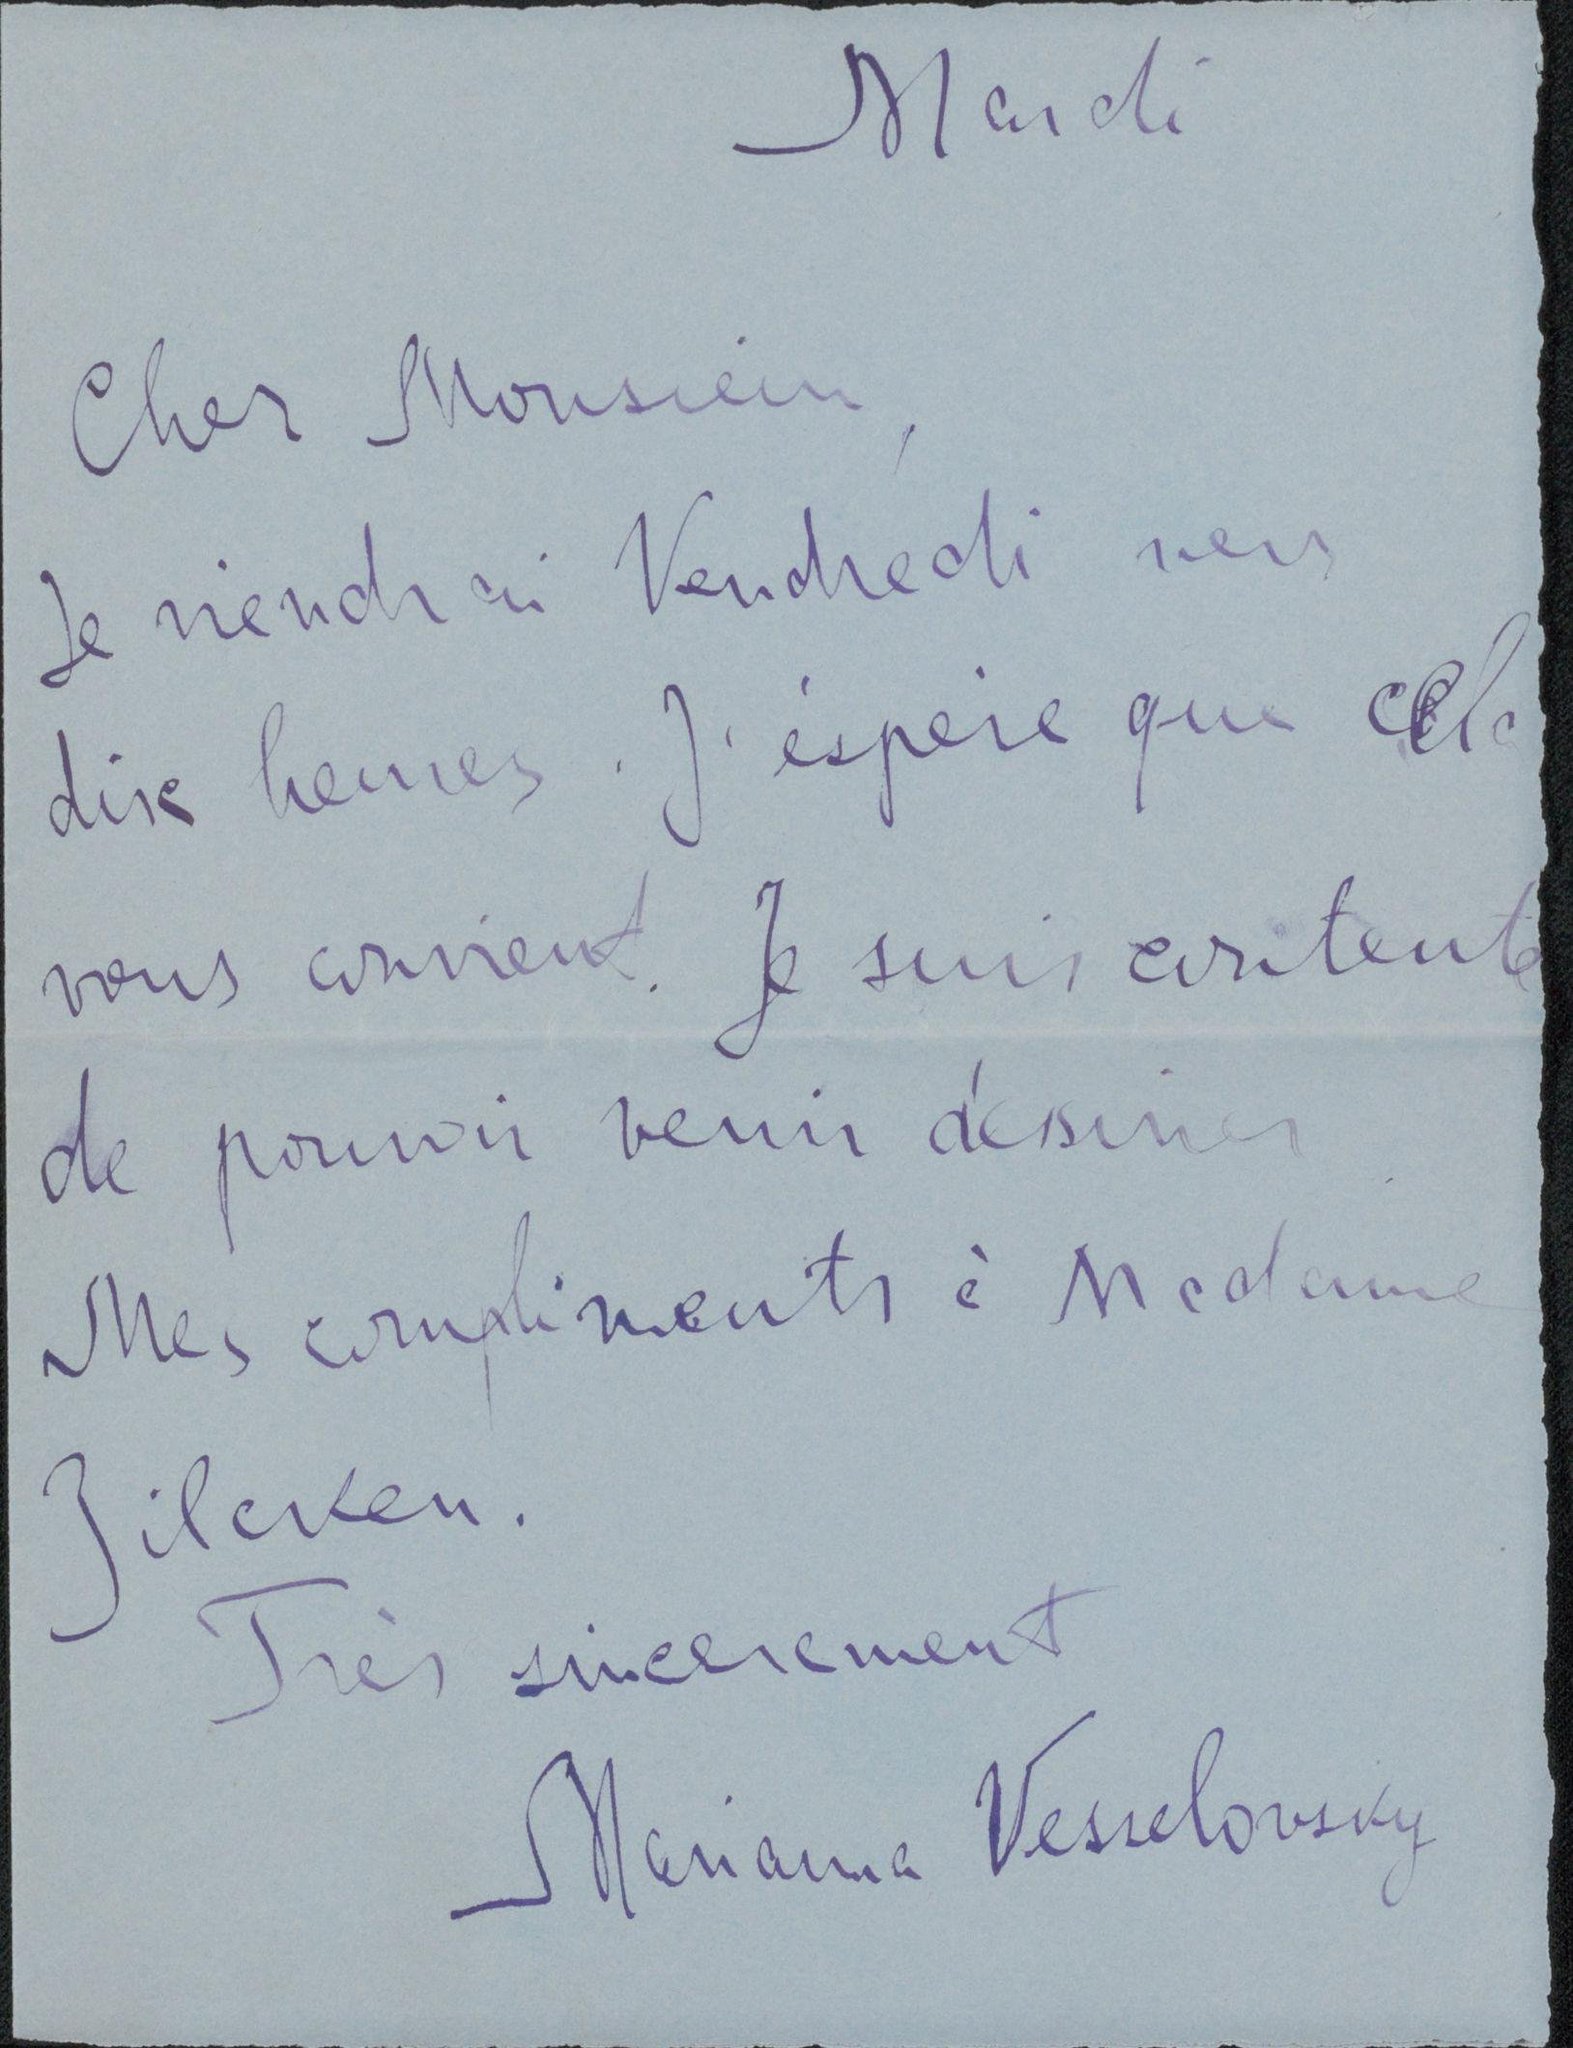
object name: letter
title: Brief aan Philip Zilcken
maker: marianne von der launitz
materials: ink, paper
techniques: pen, writing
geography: nice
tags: painter, philip zilcken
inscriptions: collector's mark: ‘RPK’